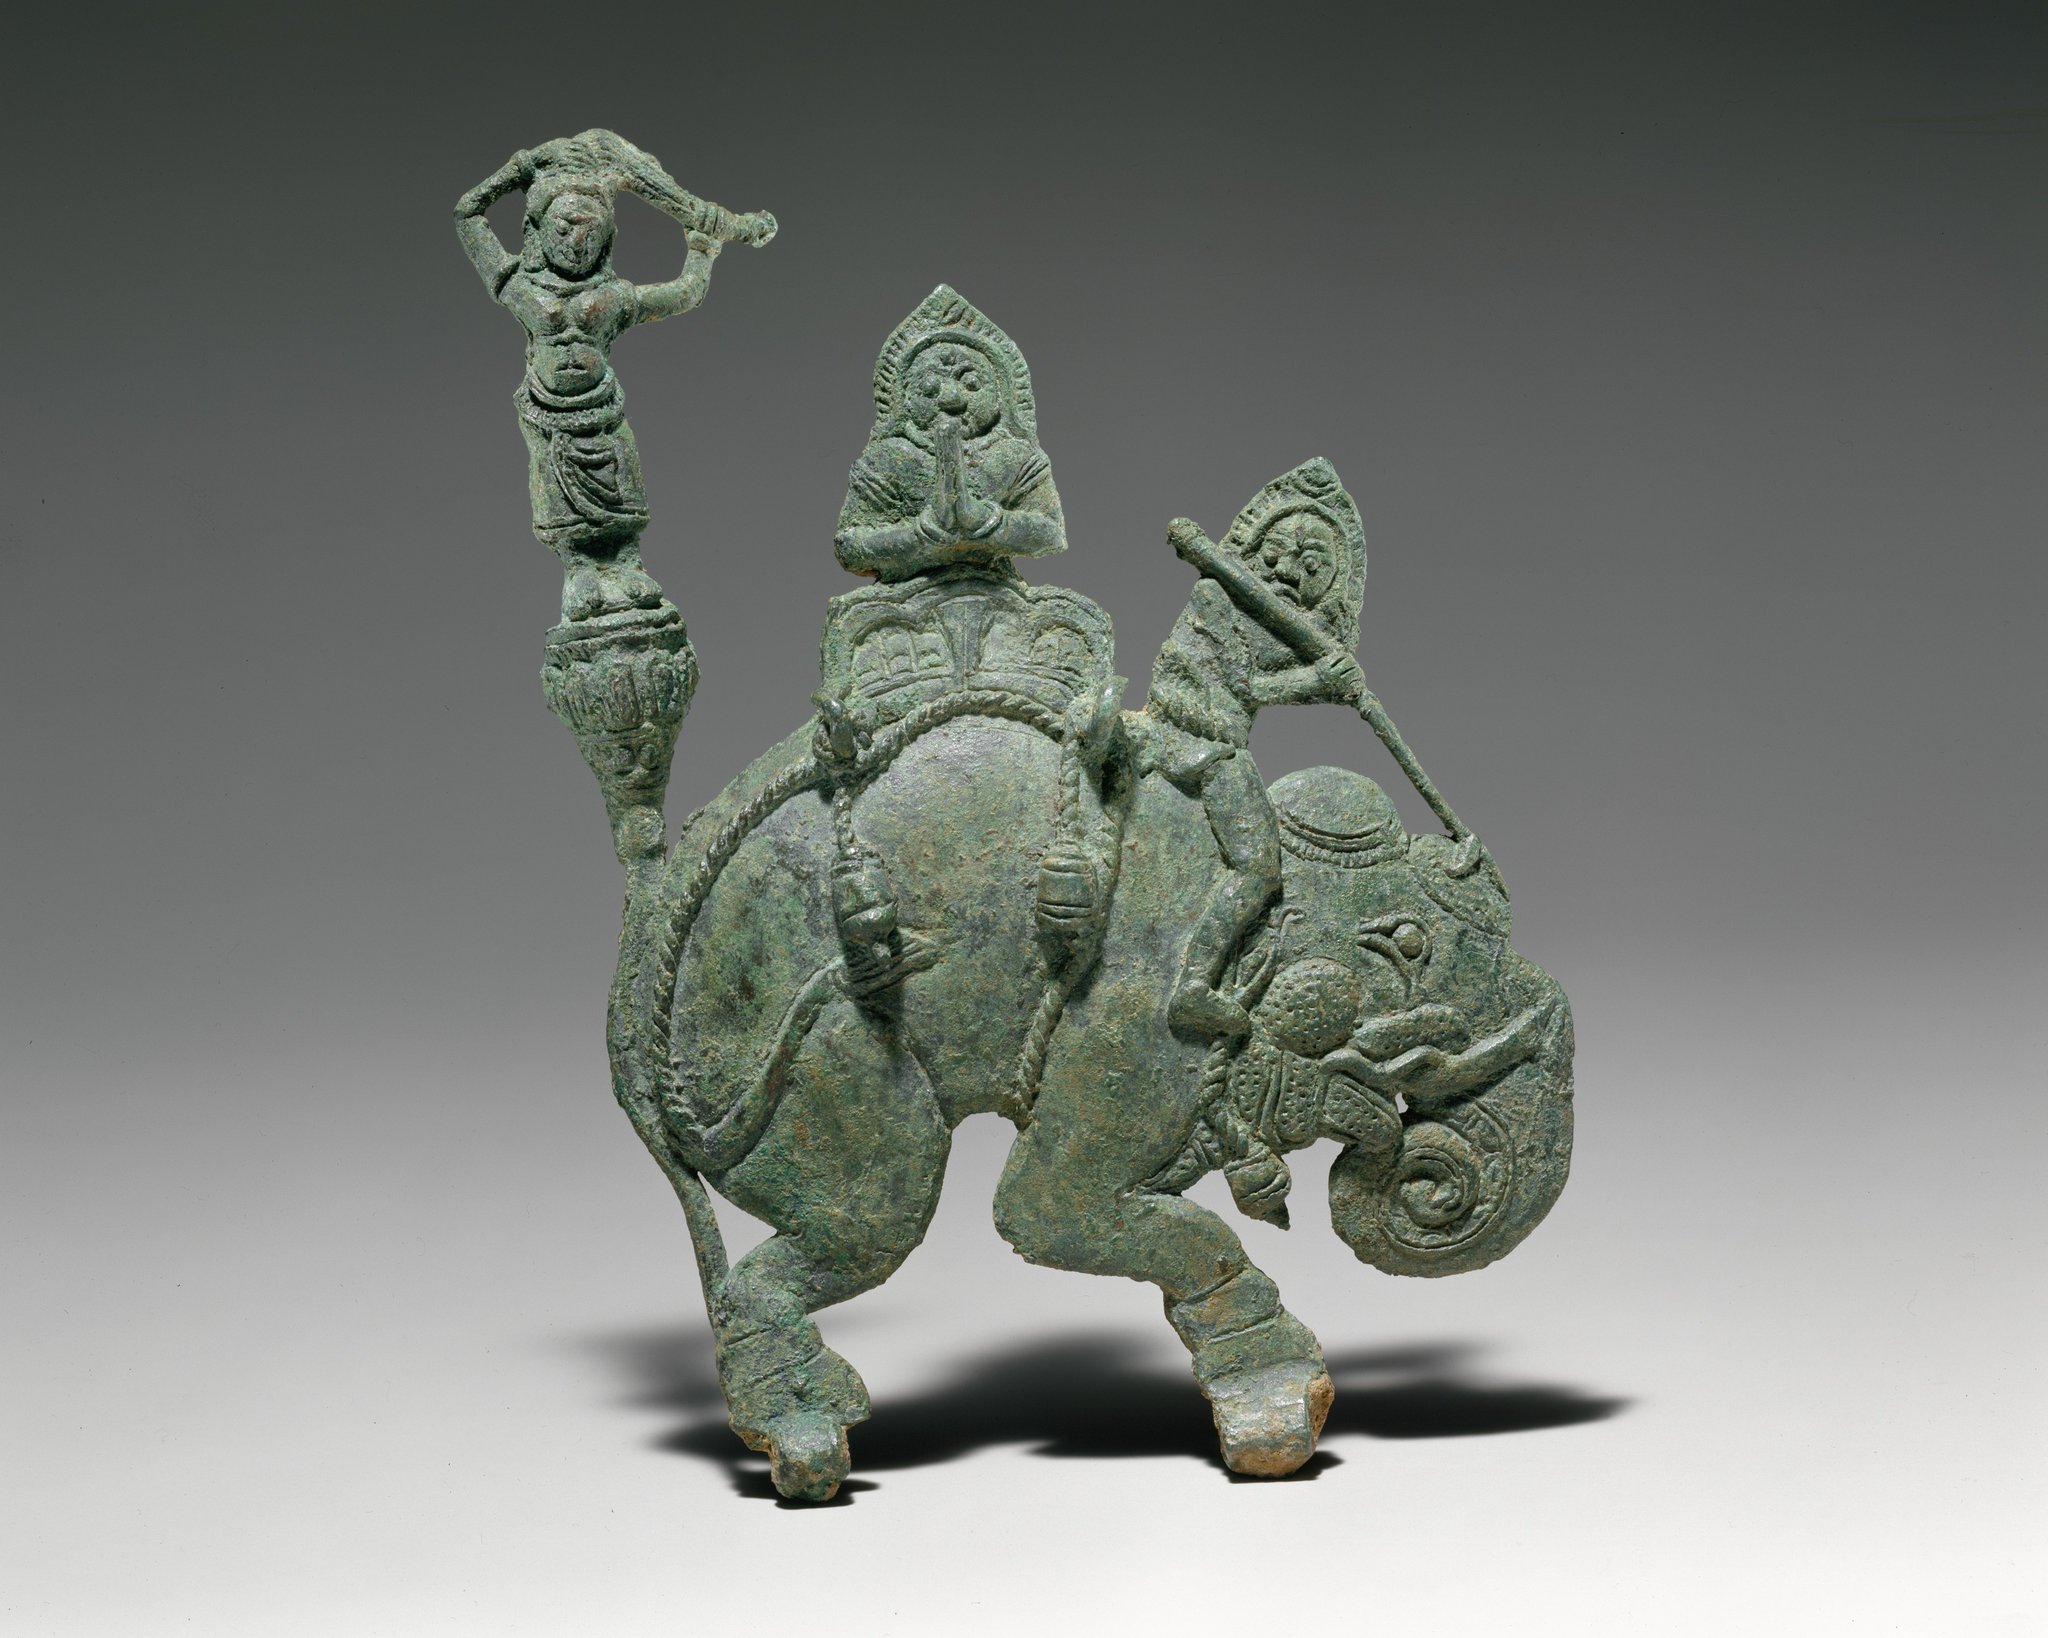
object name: plaque one of two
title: Demons on an Elephant with Nan Brah Dharani, the Earth Goddess, Wringing Water from Her Hair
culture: cambodian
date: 1167-1233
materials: bronze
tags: elephants,demons,goddess